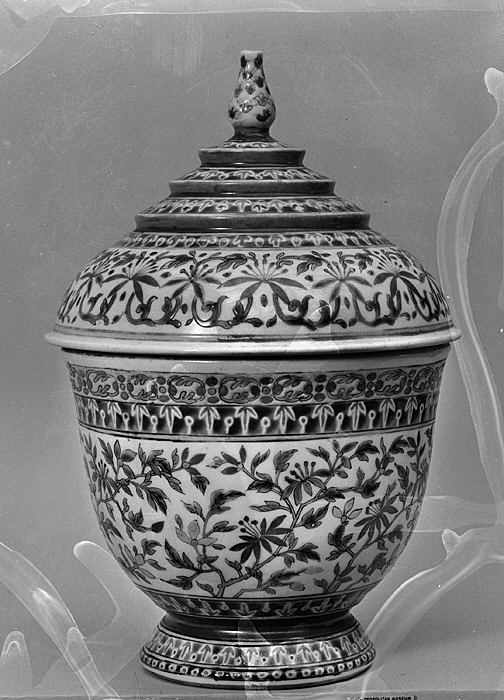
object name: covered bowl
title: Covered bowl with floral pattern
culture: chinese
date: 1801-1900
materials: enamel, porcelain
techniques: overglaze, painting, polychrome